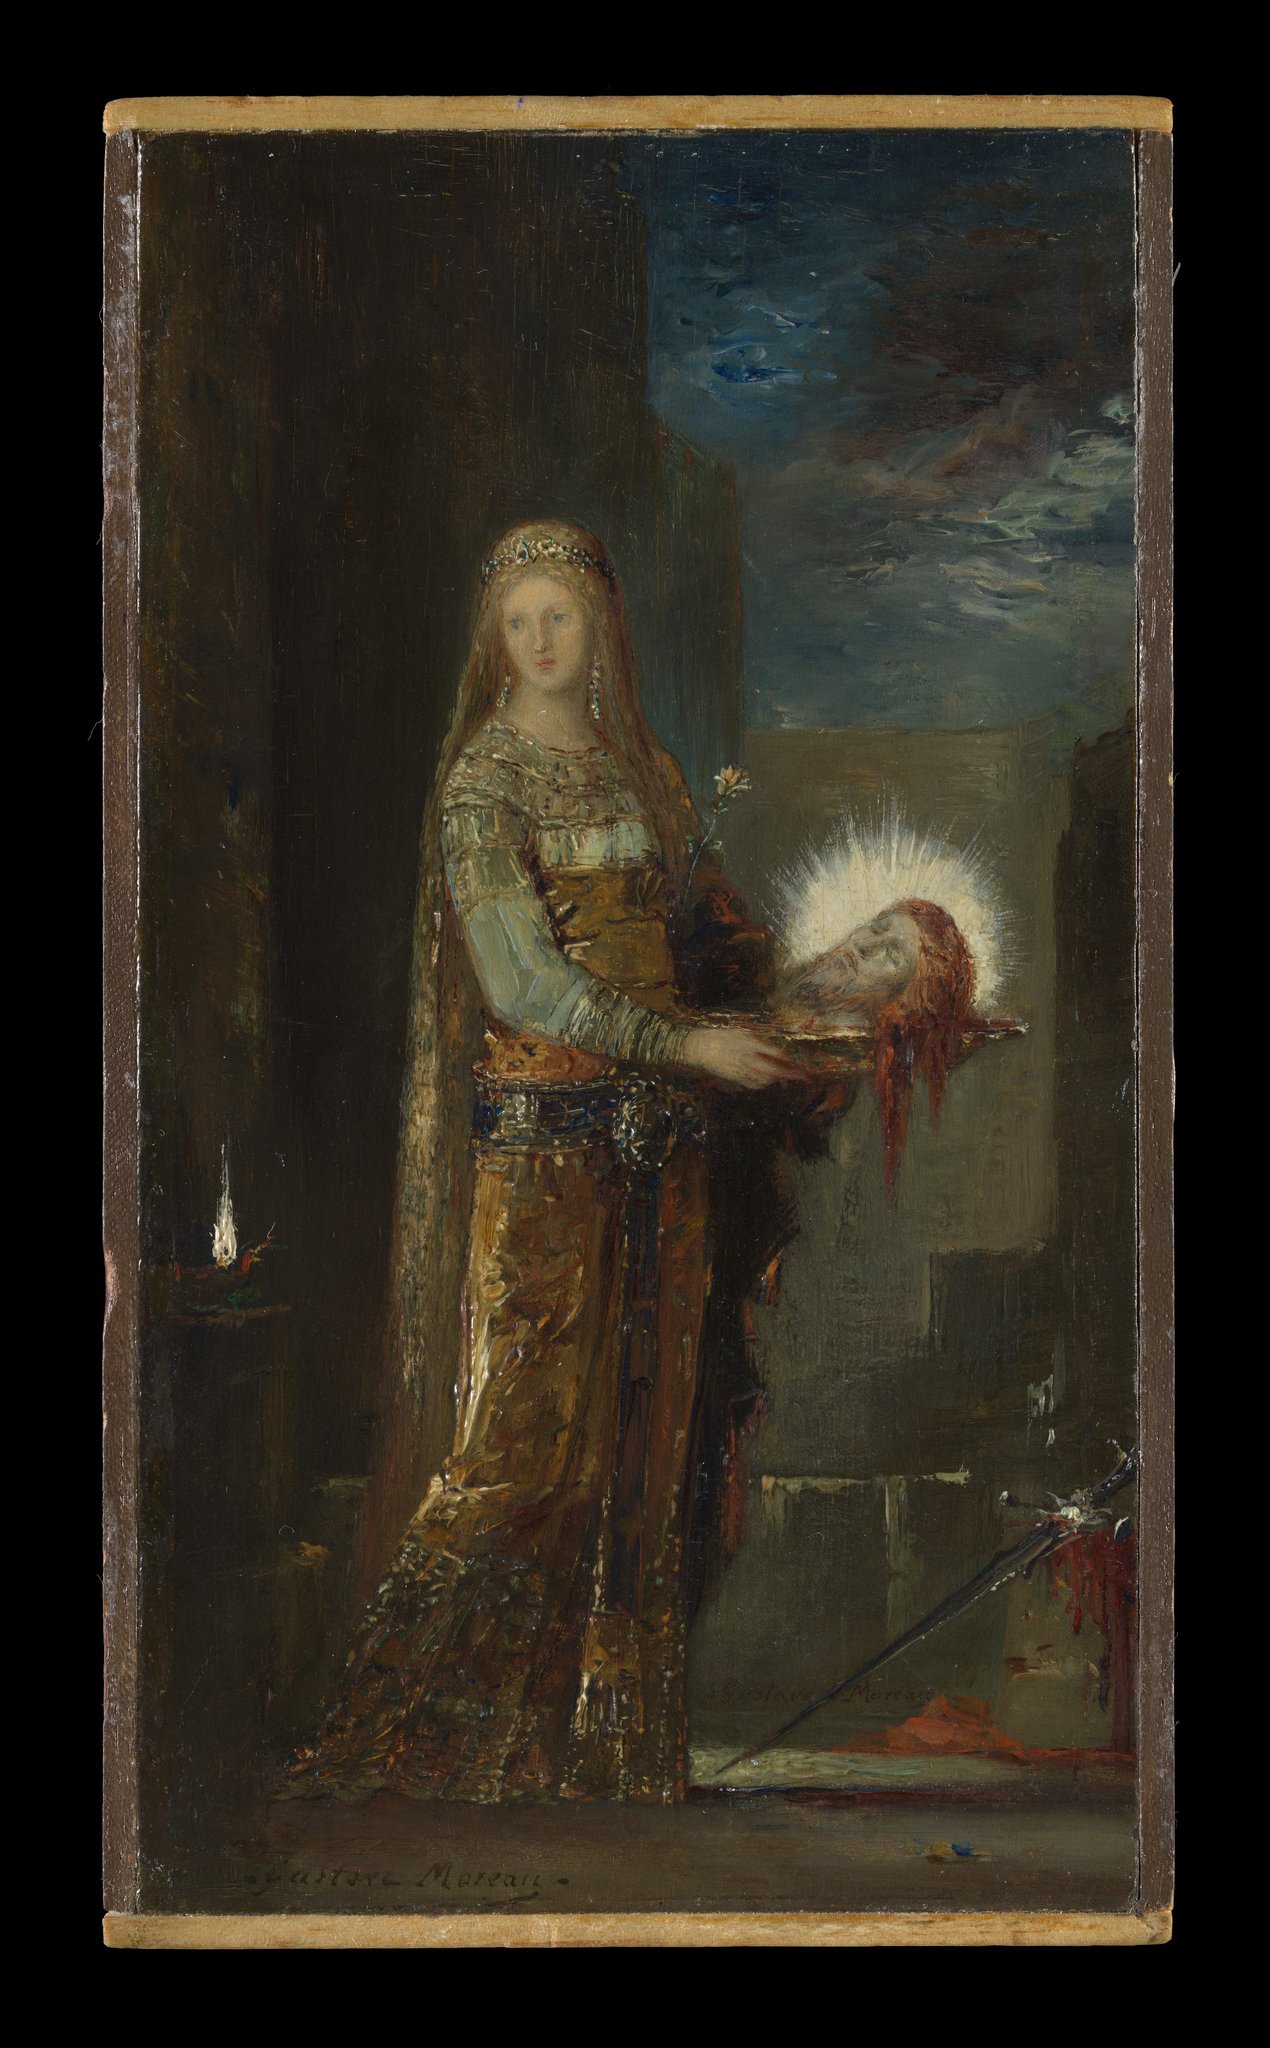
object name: painting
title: Salome with the Head of John the Baptist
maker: gustave moreau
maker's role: artist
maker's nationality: french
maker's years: 1826-1898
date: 1876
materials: oil, wood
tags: heads,saint john the baptist,salome